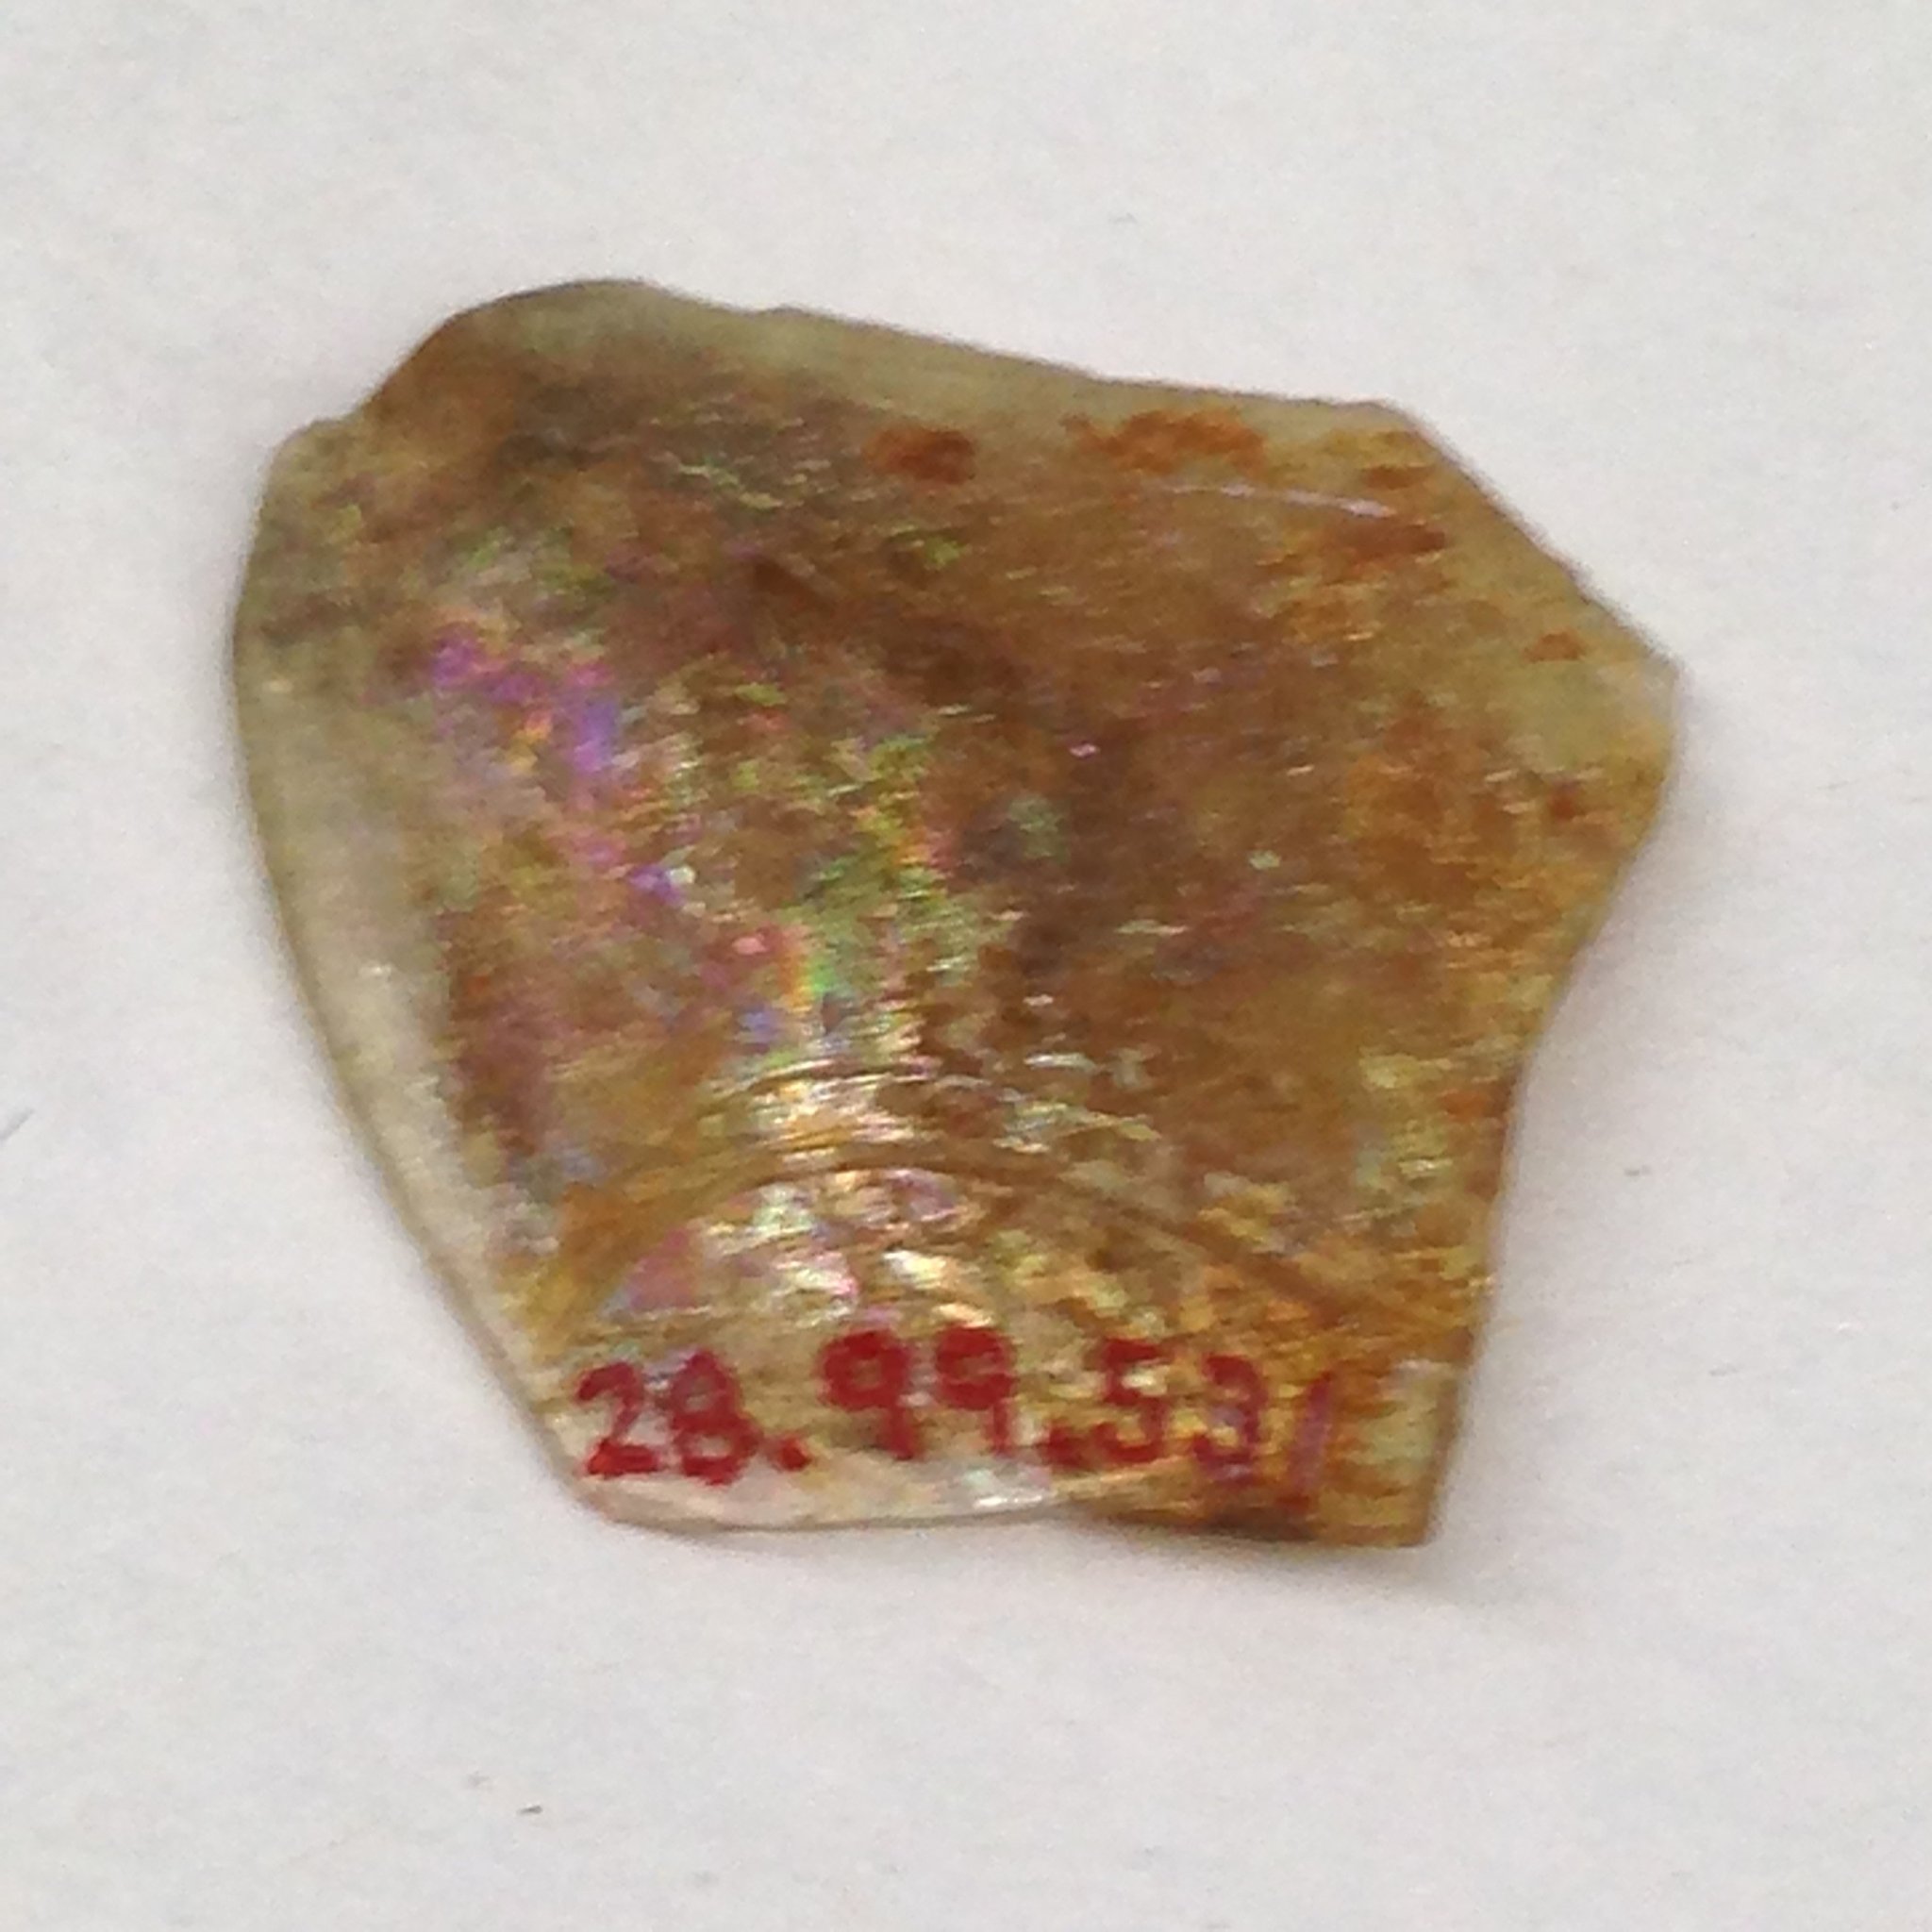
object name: fragment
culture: european or middle eastern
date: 1150-1250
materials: ceramic, glass